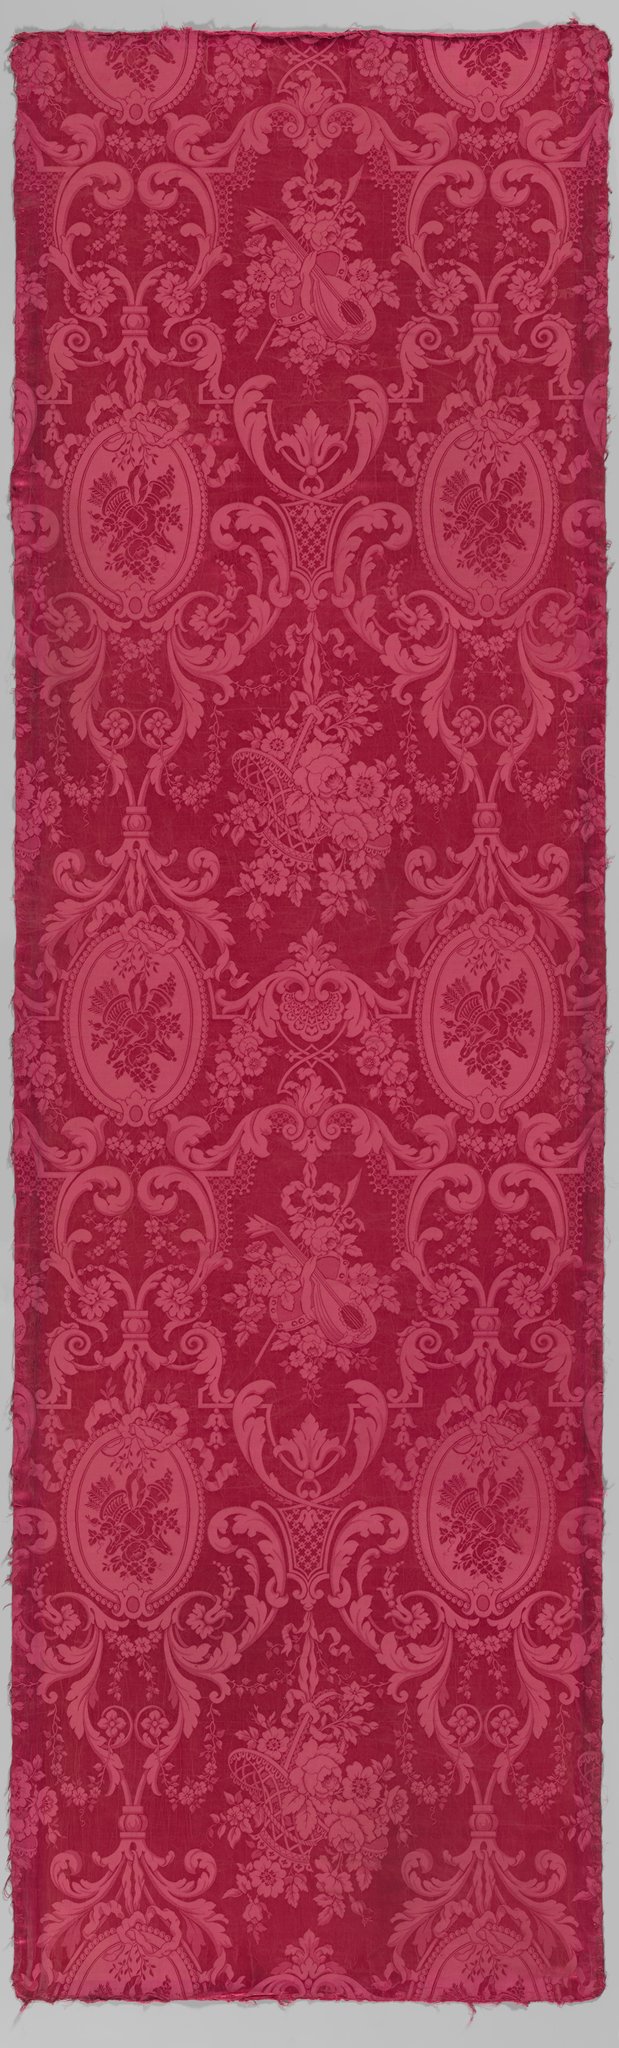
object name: upholstered wall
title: Fragment van een wandbespanning van cerise-rood zijden damast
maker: Anonymous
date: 1850-1875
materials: silk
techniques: damask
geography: france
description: Fragment van een wandbespanning, van cerise-rood zijden damast. (In satijn-, taft- en keperbinding). Een streng symmetrisch ornament van acanthusbladeren recht- en rondlijnen begrenst twee boven elkaar gelogen spitse velden, waarbinnen onsymmetrische motieven zijn opgehangen aan een lint met strik; het ene bestaande uit een precieus bloemenmandje met naturalistisch bloemenarrangement, het andere gevormd door een mandoline en een tamboerijn. Tussenliggende velden van ongeveer gelijke grootte, en verspringend met de eerste, dragen een ovaal medaillon met parelrand, eveneens hangende aan gestrikte linten, beginnende bij de knooppunten van het acanthus-ornament. De medaillons zijn gevuld met twee gekruiste hoorns van overvloed. Het hoofdornament is verlevendigd met fijne slingerende takjes en symmetrische veldjes met netvulling. Dit fragment is afkomstig van de balzaal in de ambtswoning van de burgemeester van Amsterdam, Herengracht 502, in september 1950 gesloopt.